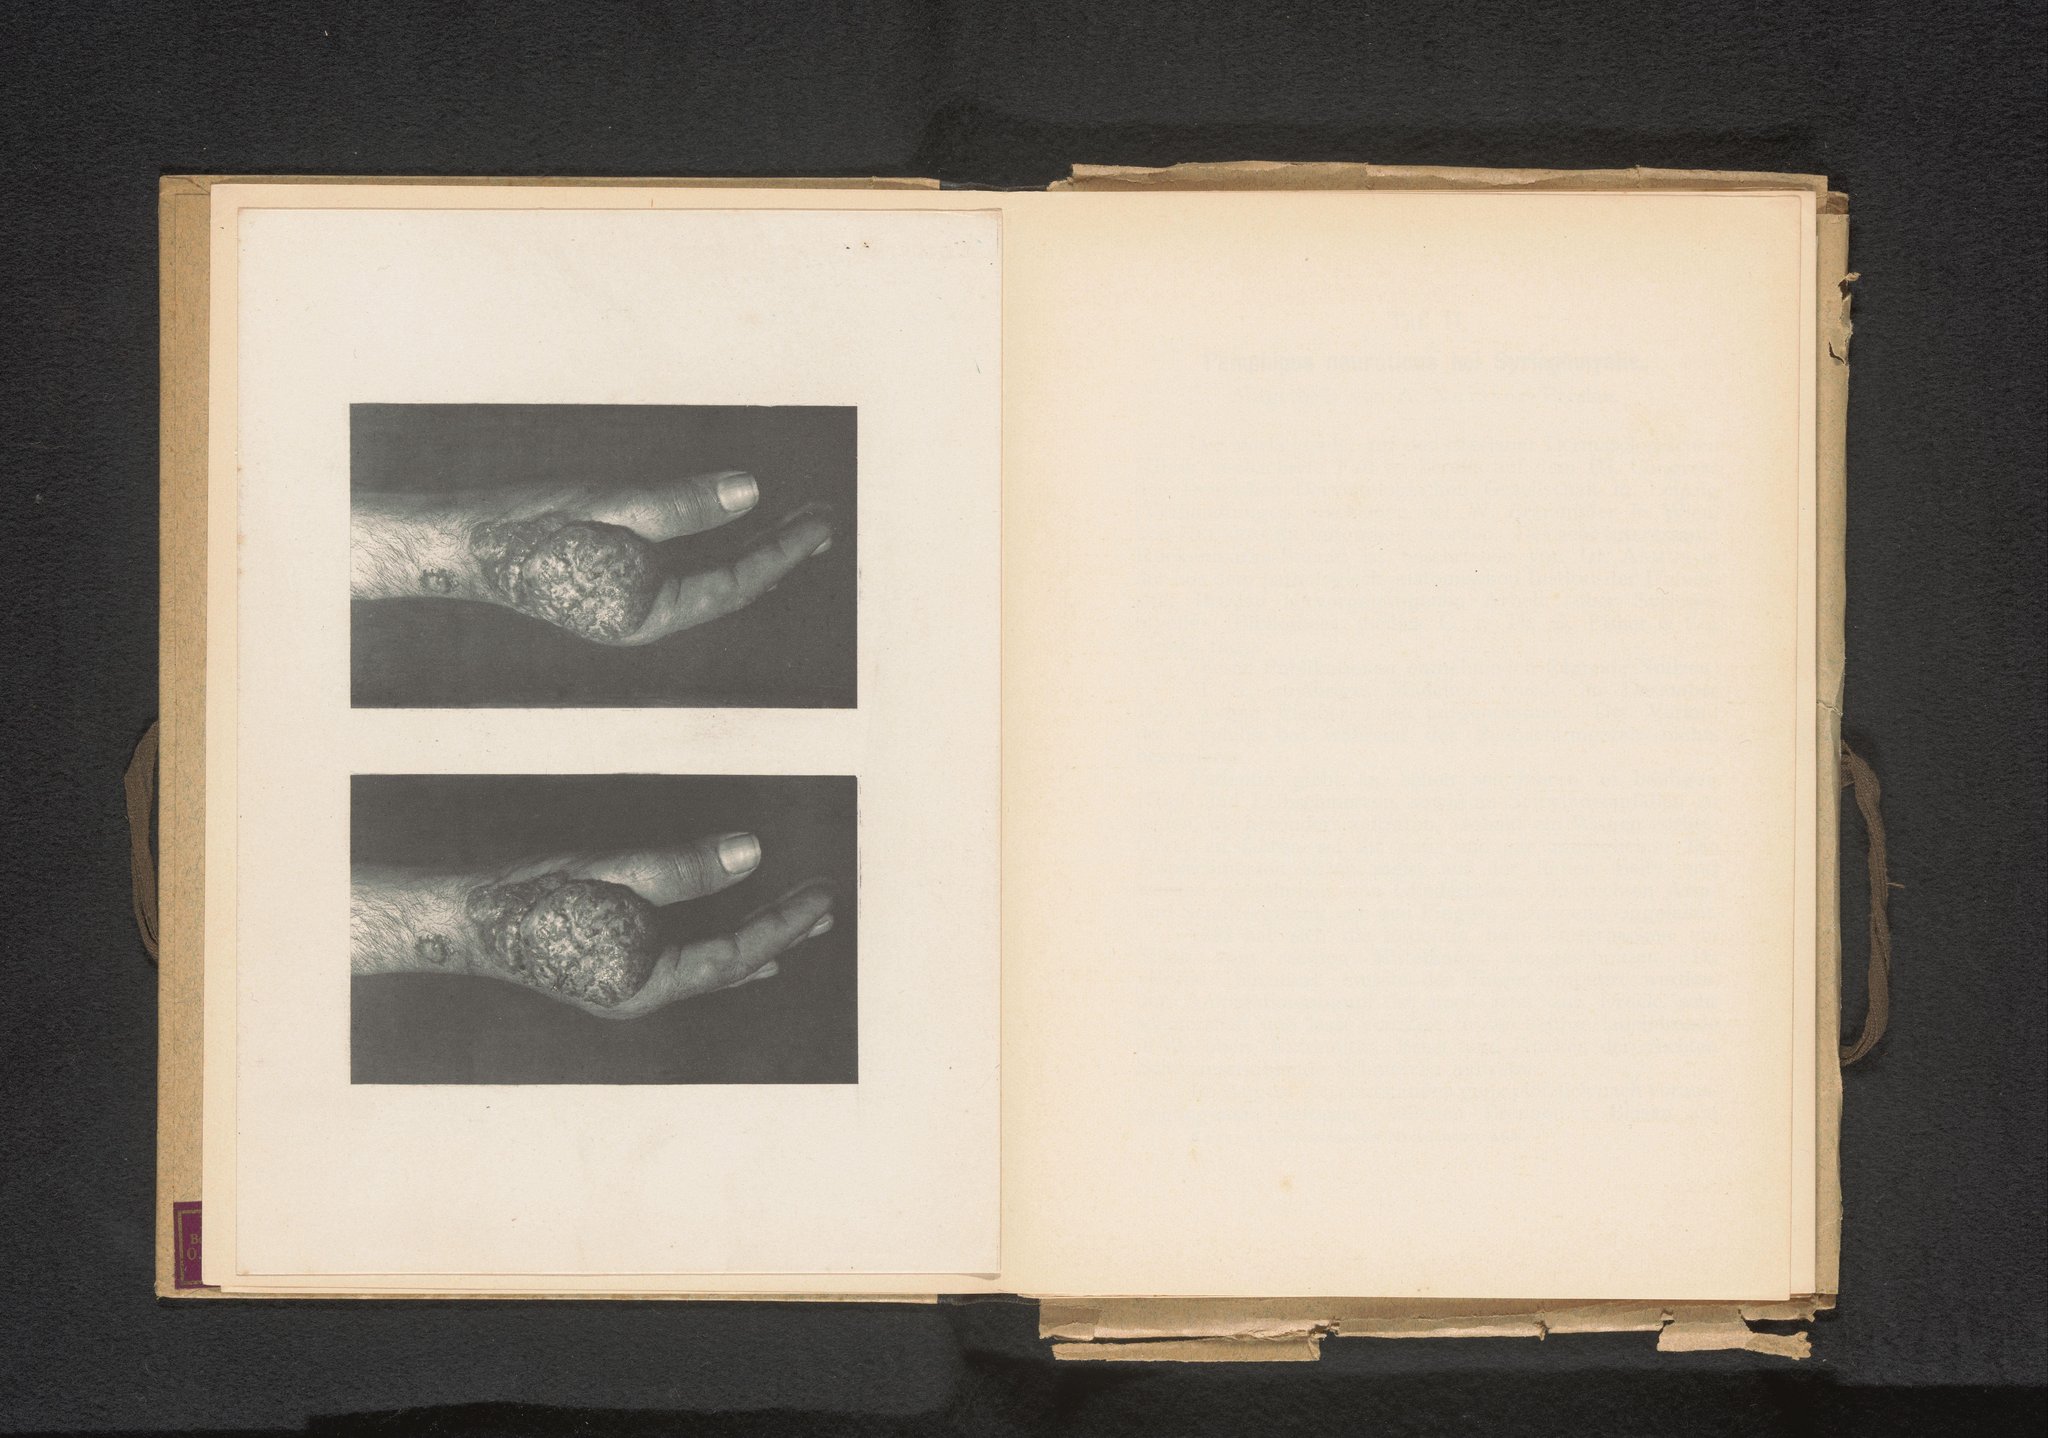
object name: stereograph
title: Twee aanblikken van een hand met een carcinoom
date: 1884-1894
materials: paper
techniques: photoaquatint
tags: external tumours, skin and venereal diseases, hand